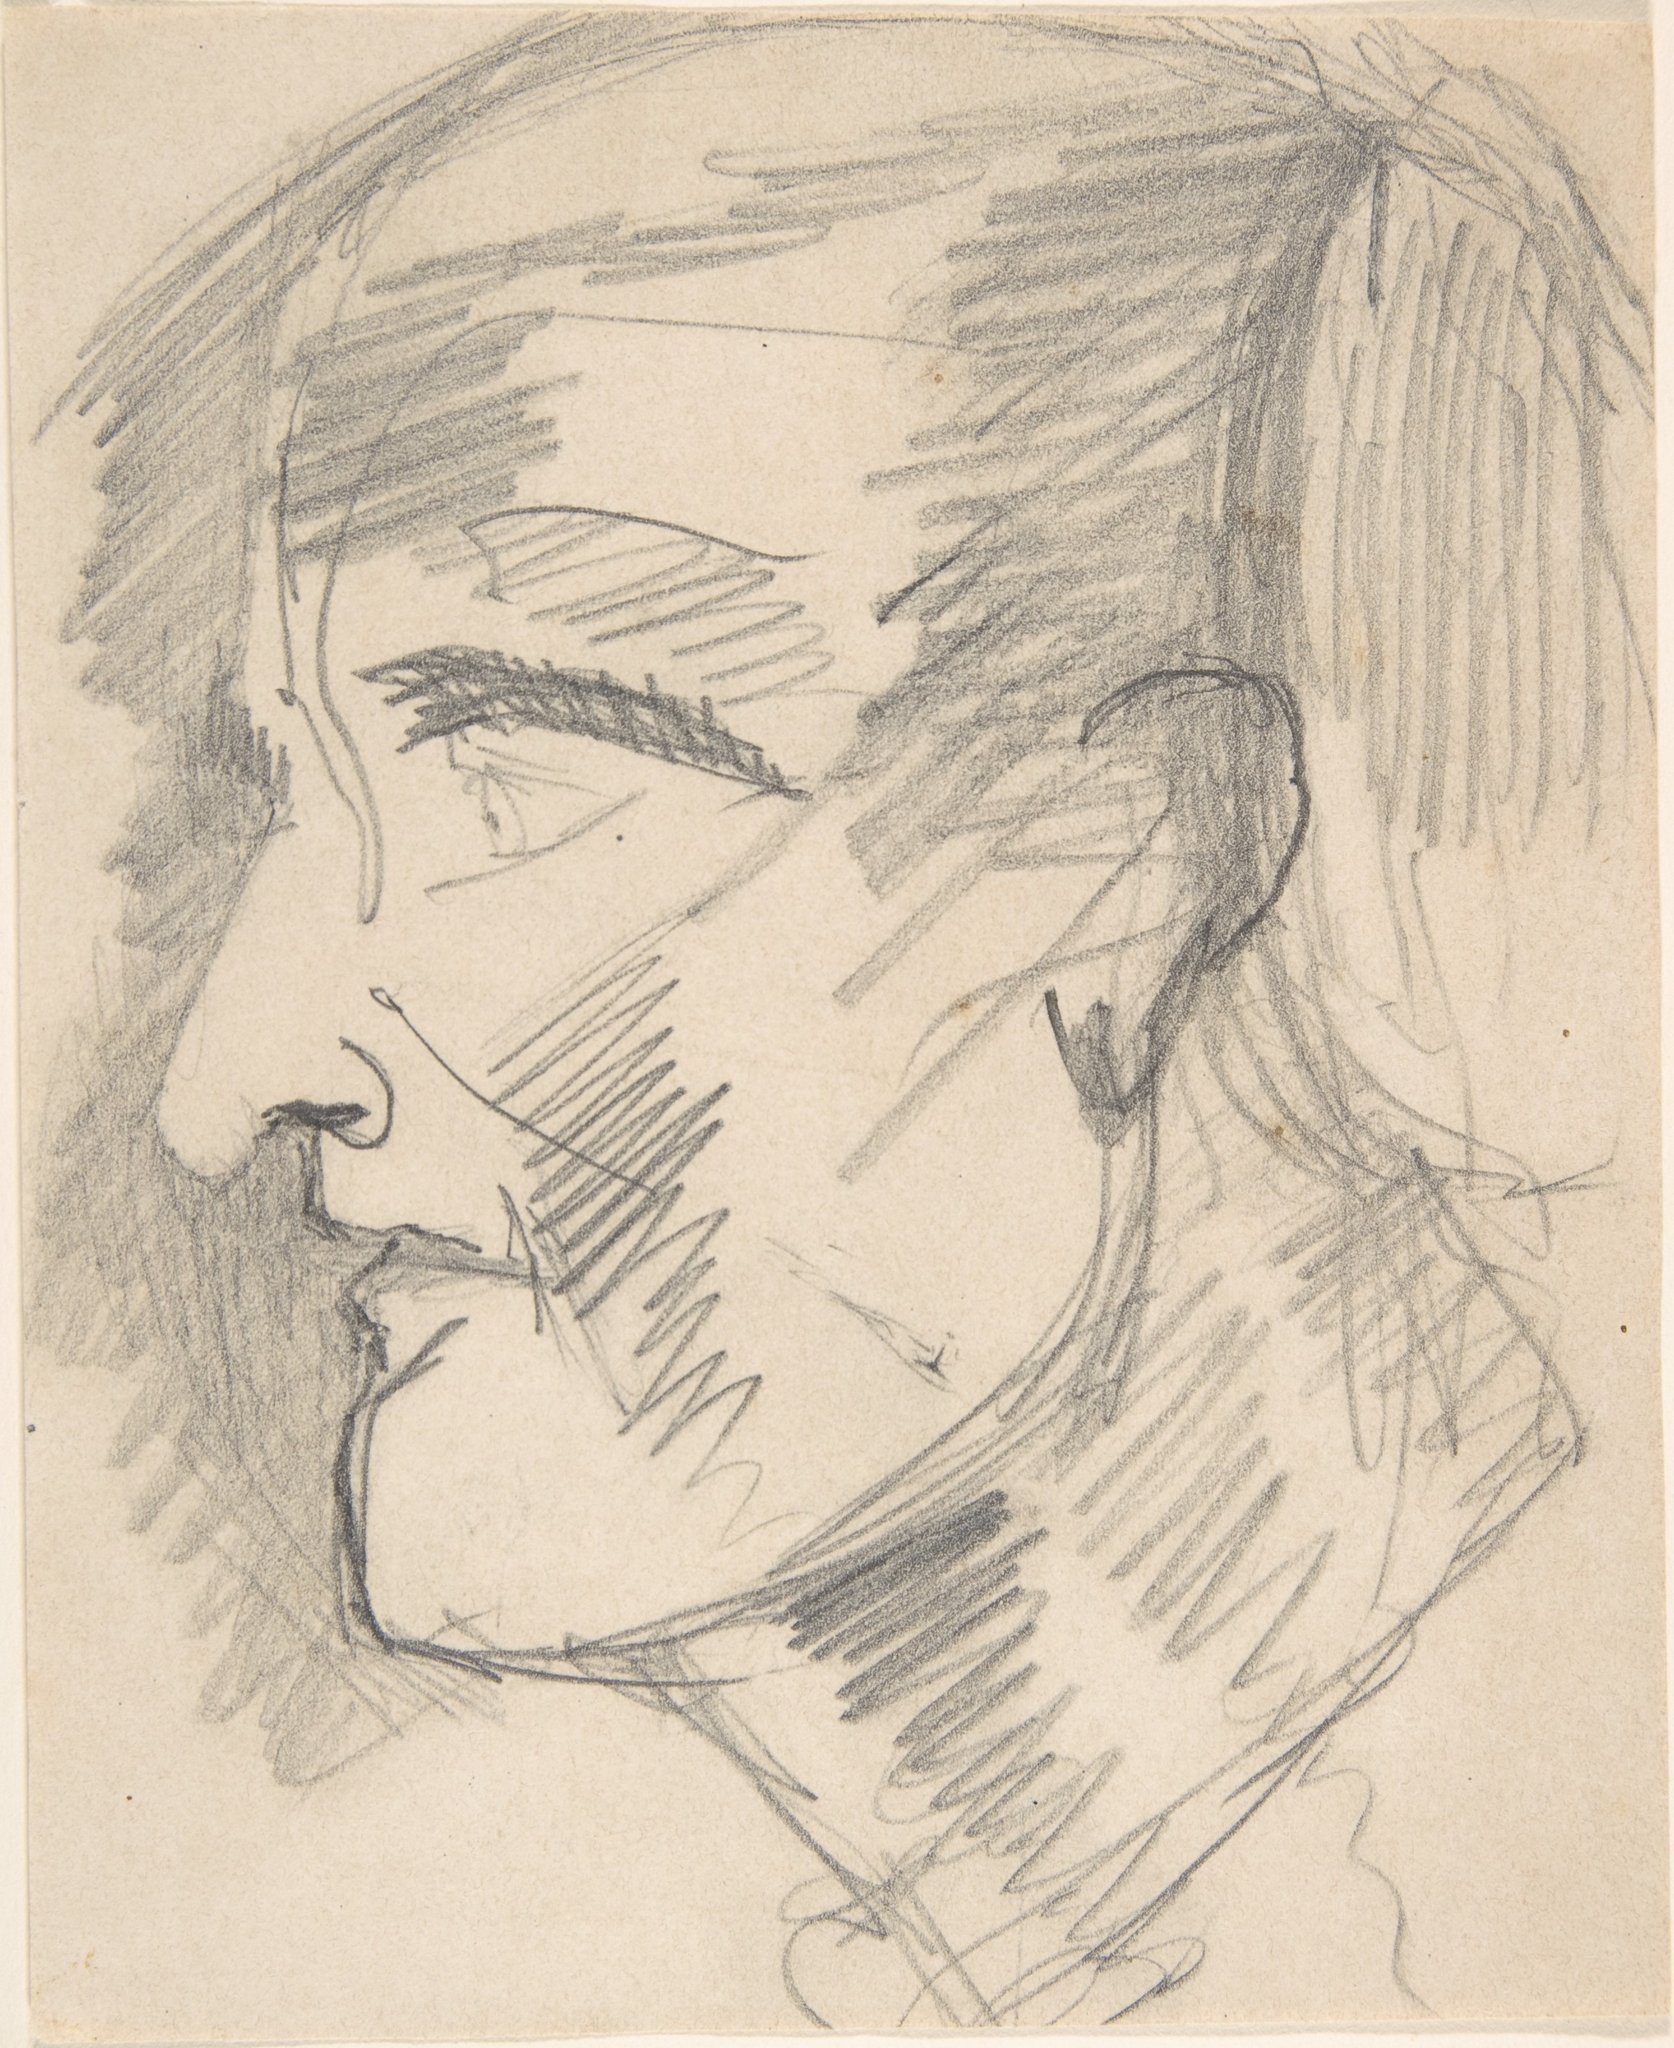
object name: drawing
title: Notebook with sketches and notes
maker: félicien rops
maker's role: artist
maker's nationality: belgian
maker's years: 1833-1898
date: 1833-1898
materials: graphite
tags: men,profiles